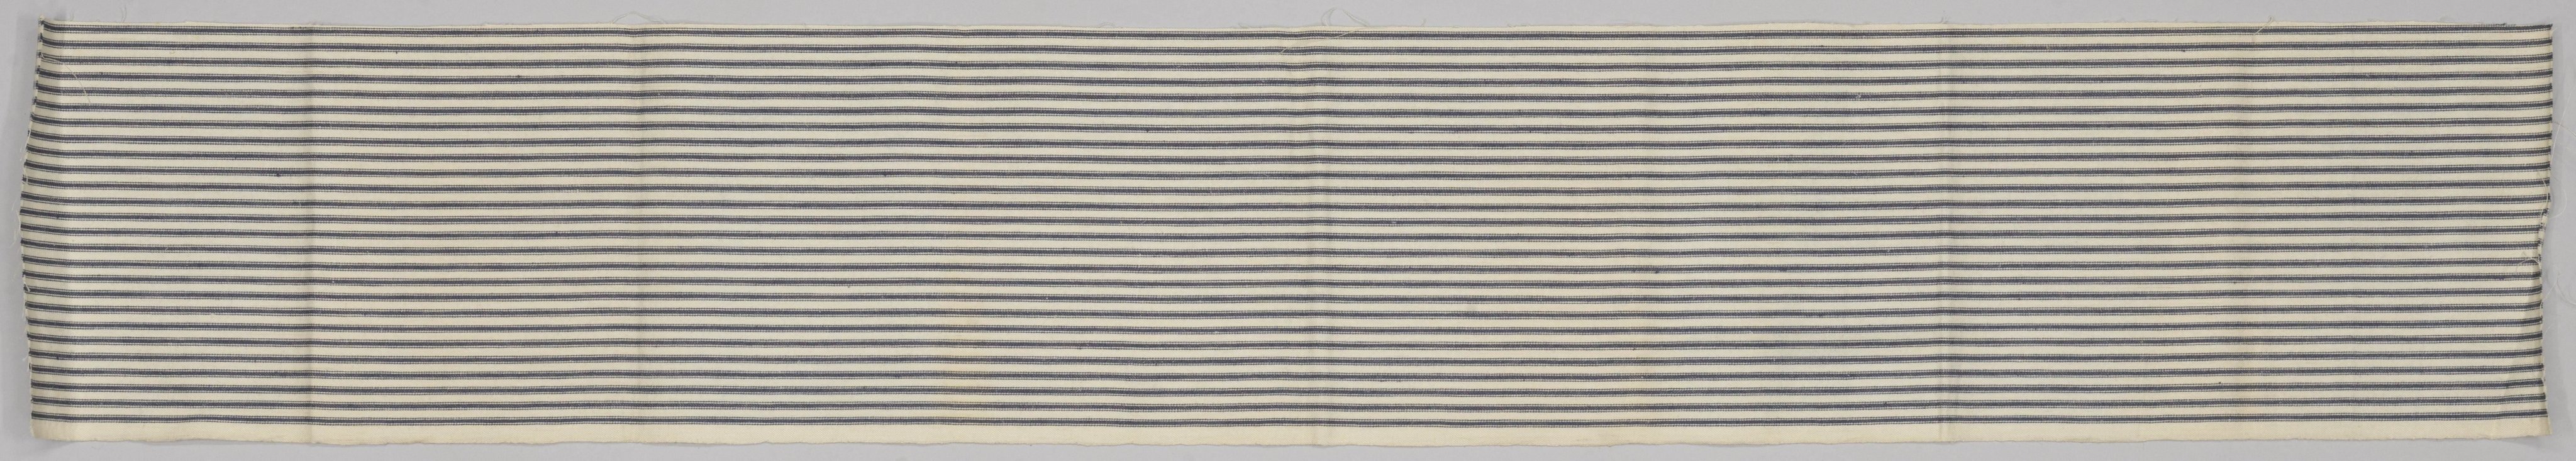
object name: tick covering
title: Fragment van een beddentijk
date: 1850-1900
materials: cotton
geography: netherlands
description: Fragment van een beddentijk, katoenen visgraat, blauwgestreept.